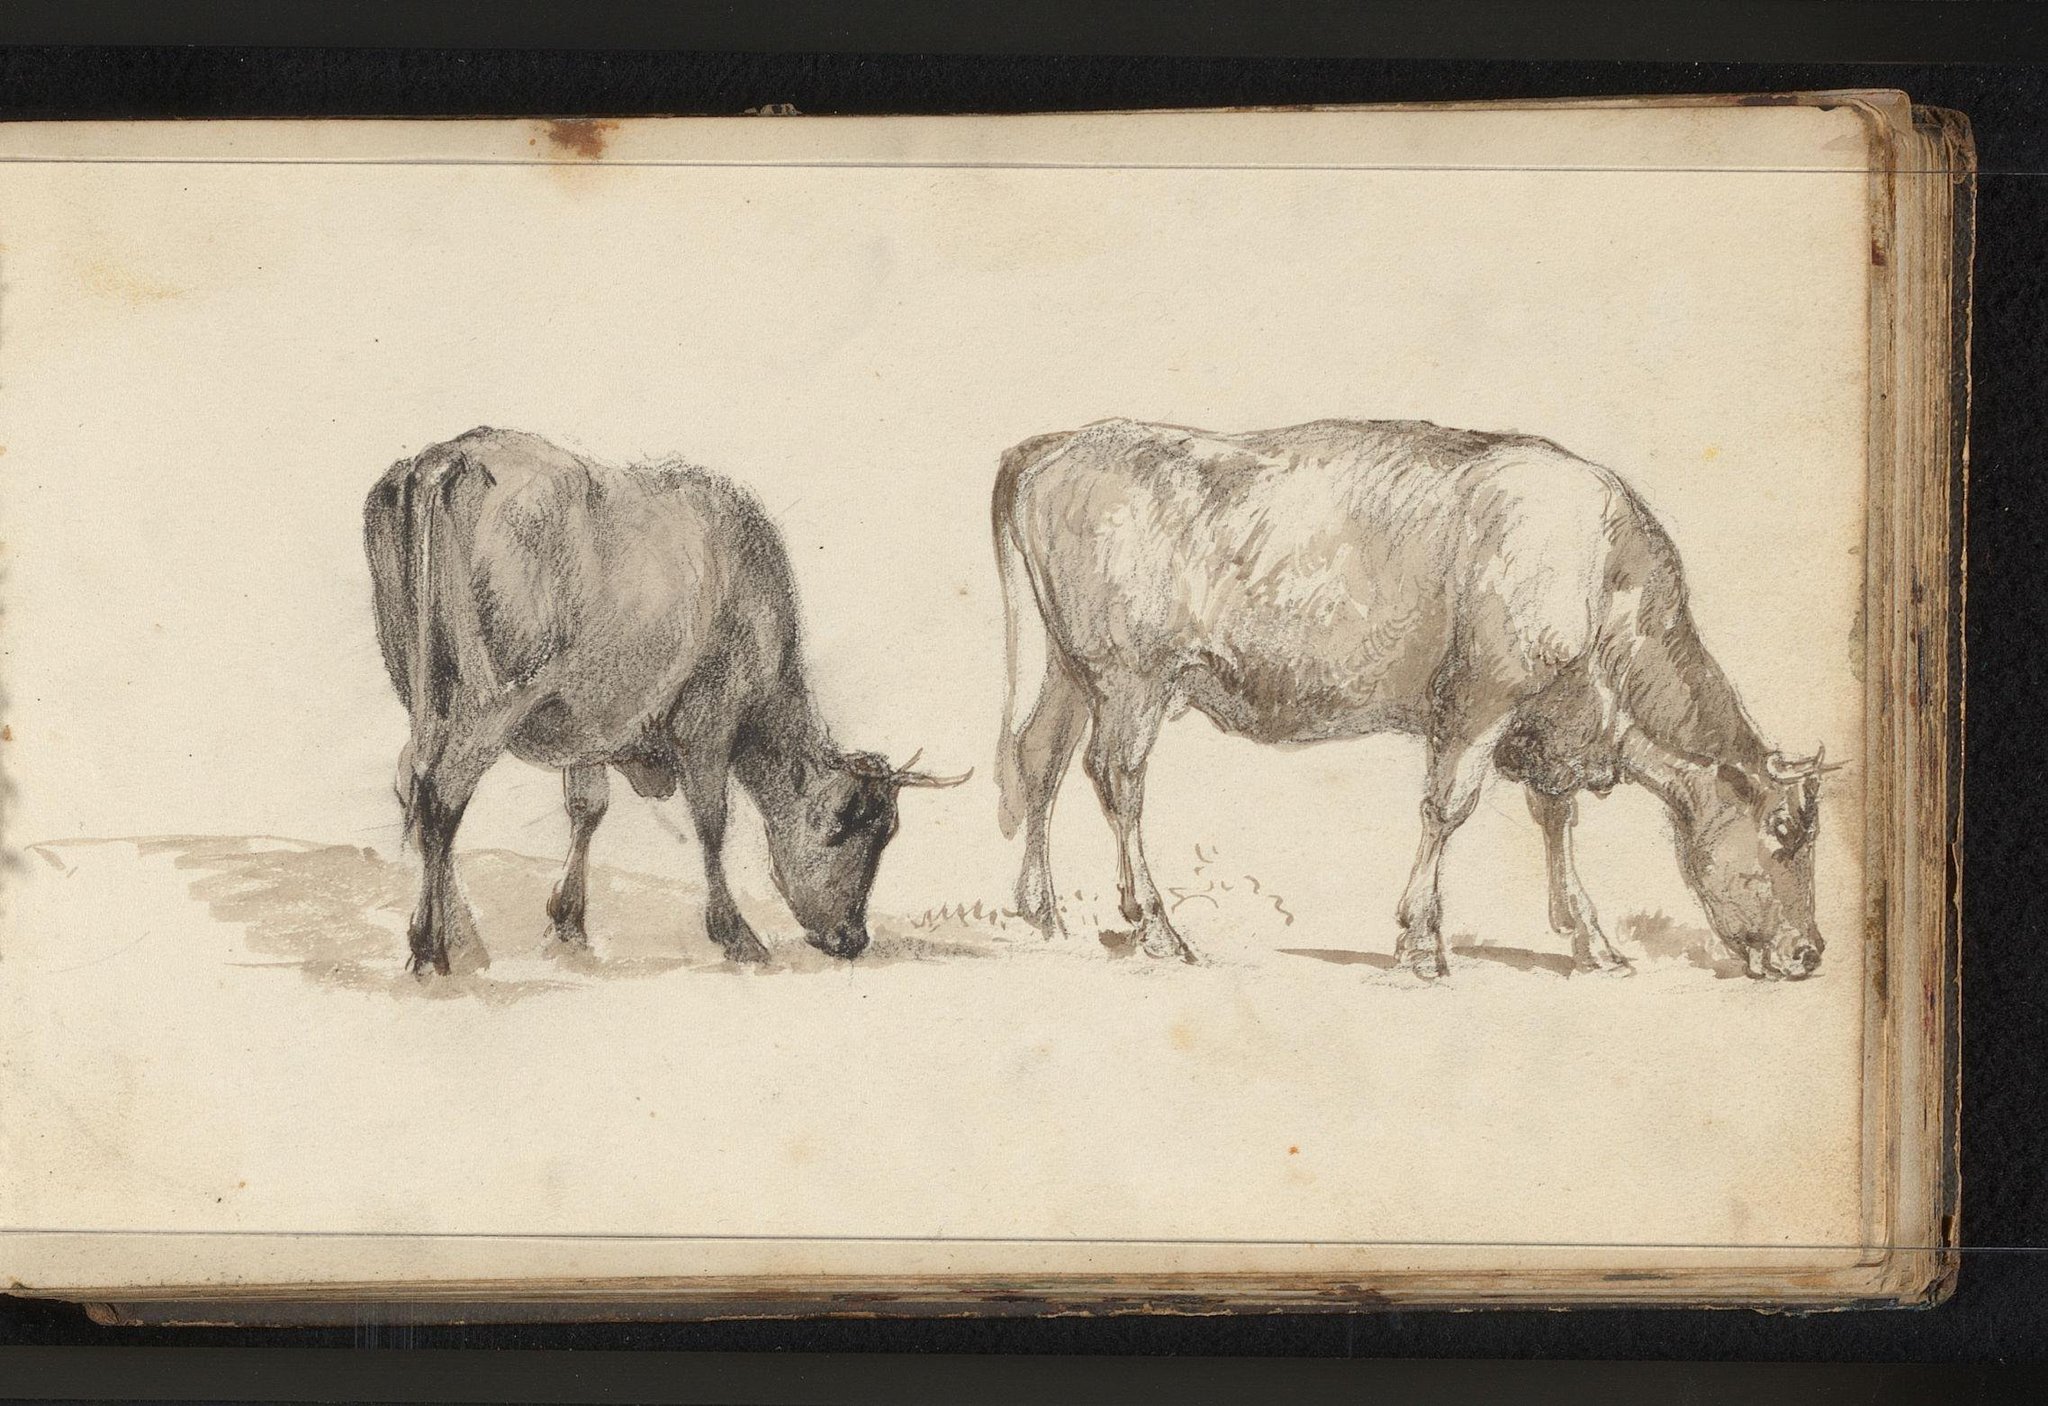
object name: sketchbook leaf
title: Twee grazende stieren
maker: jan bedijs tom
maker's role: draughtsman, painter, print maker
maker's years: 1813-1894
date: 1828-1894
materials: paper, pencil, watercolor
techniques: brush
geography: the hague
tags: bull, landscapes, artist (in general) making preliminary designs, sketching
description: Pagina 46 verso uit een schetsboek met 54 bladen.